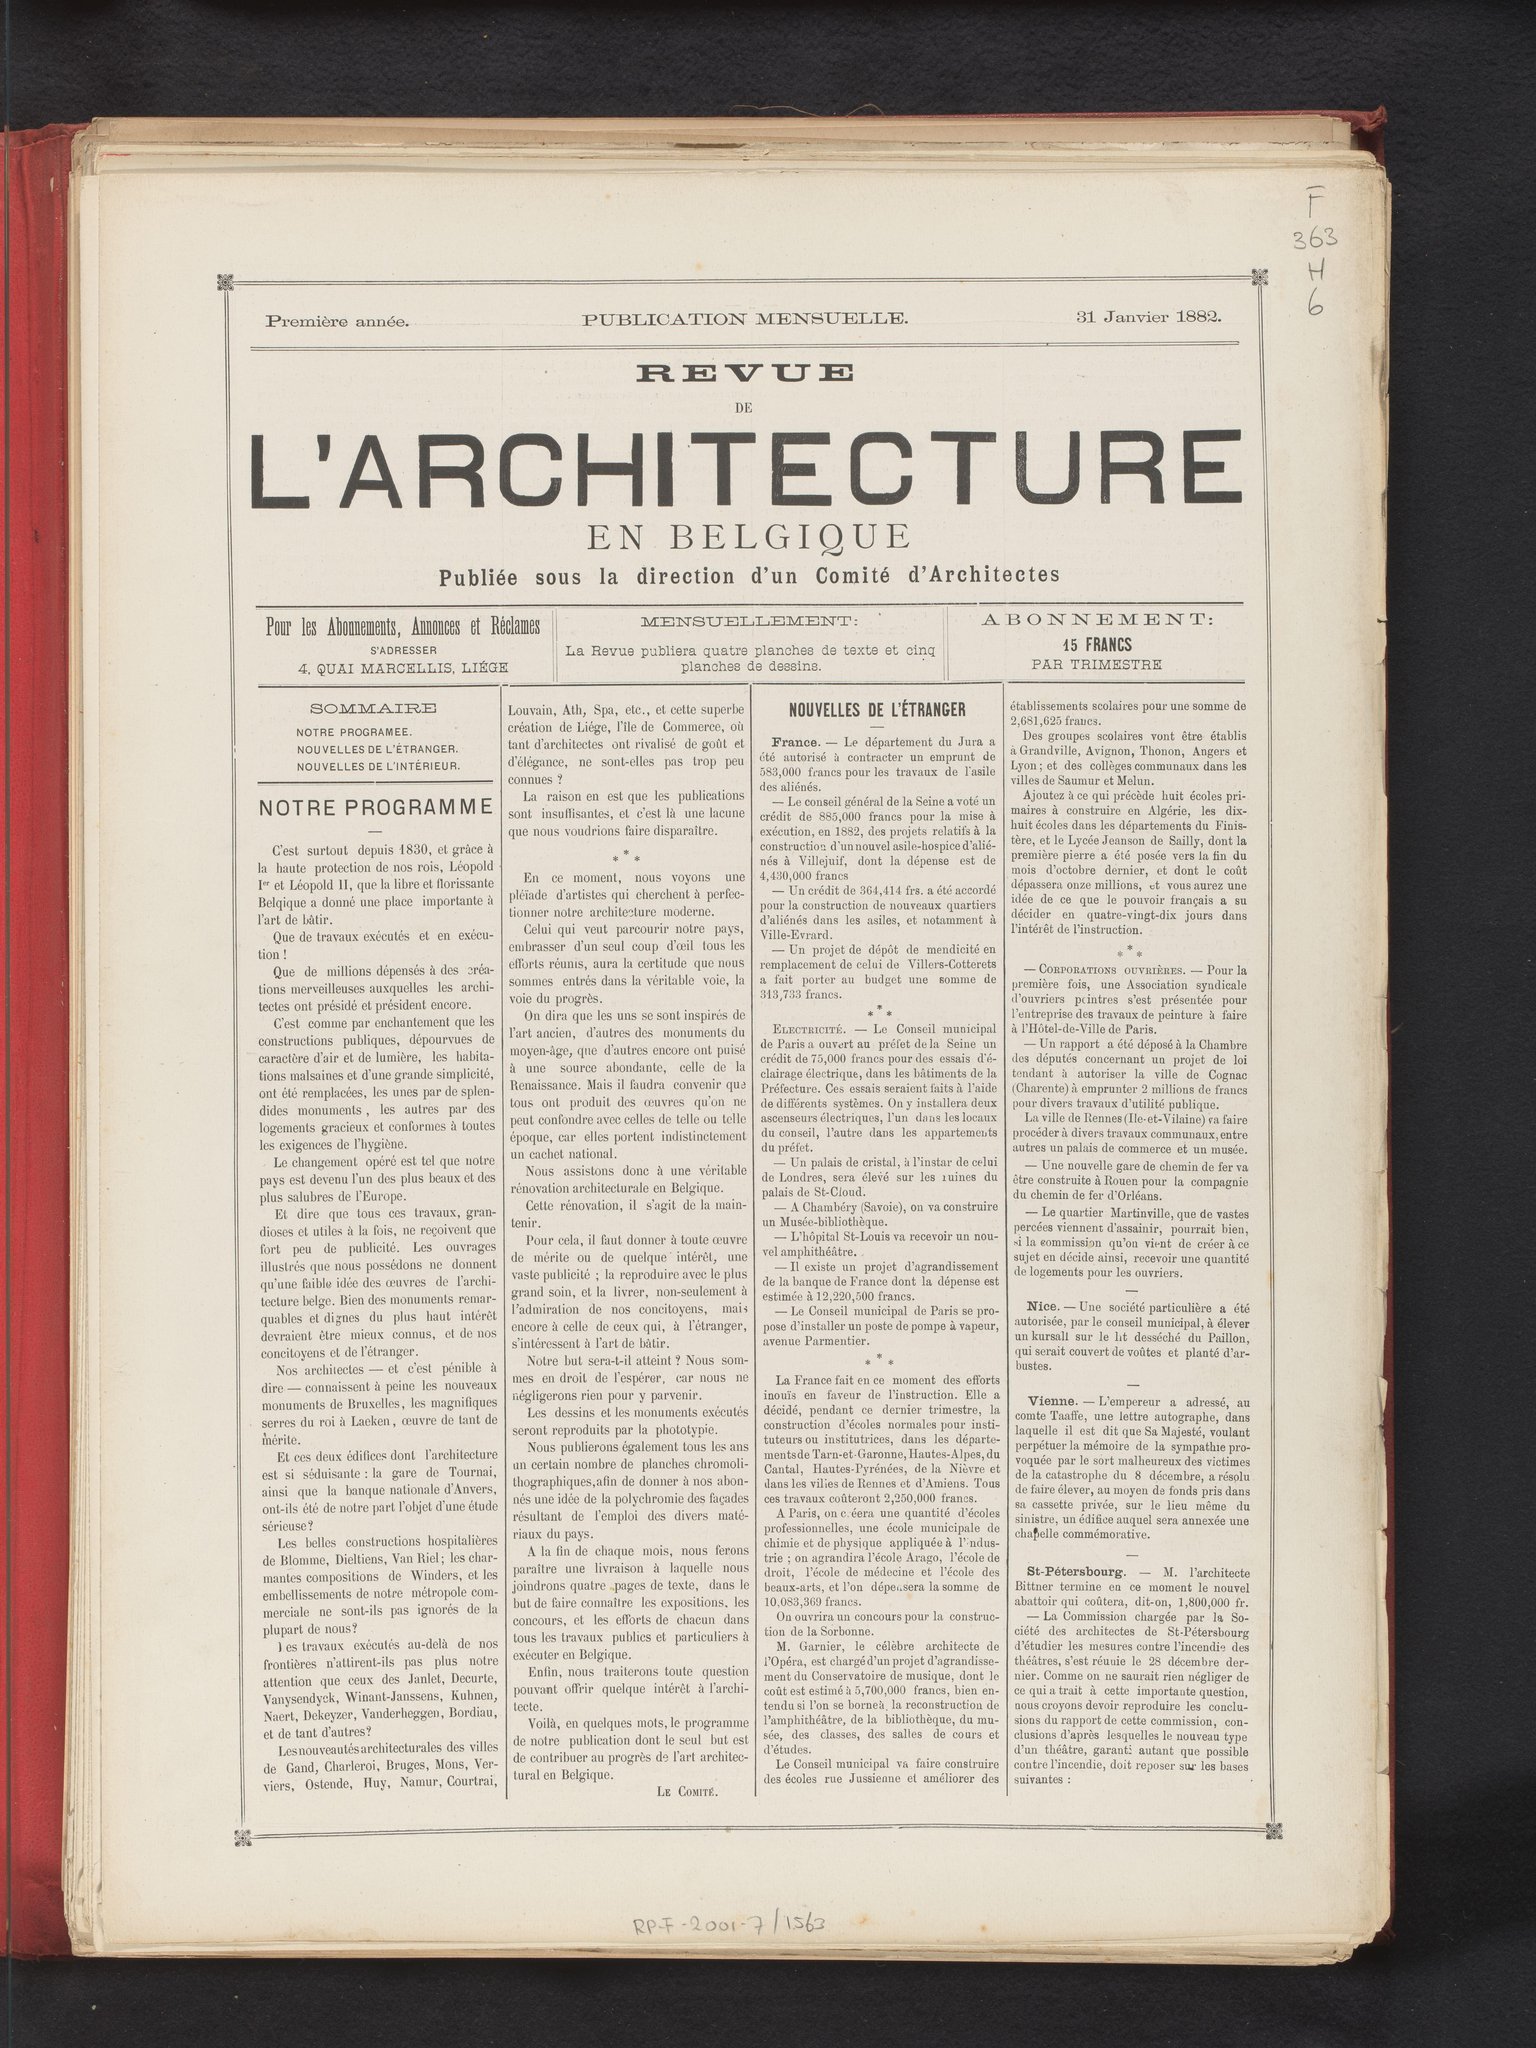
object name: wrapper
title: Revue de l'architecture en Belgique / publiée sous la direction d'un comité d'architectes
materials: cardboard, linen, paper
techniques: photograph, printing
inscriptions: date: ‘OCT/ 1992’, number: ‘N. 472’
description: Omslag met 110 prenten op 90 bladen en 18 tekstbladen.